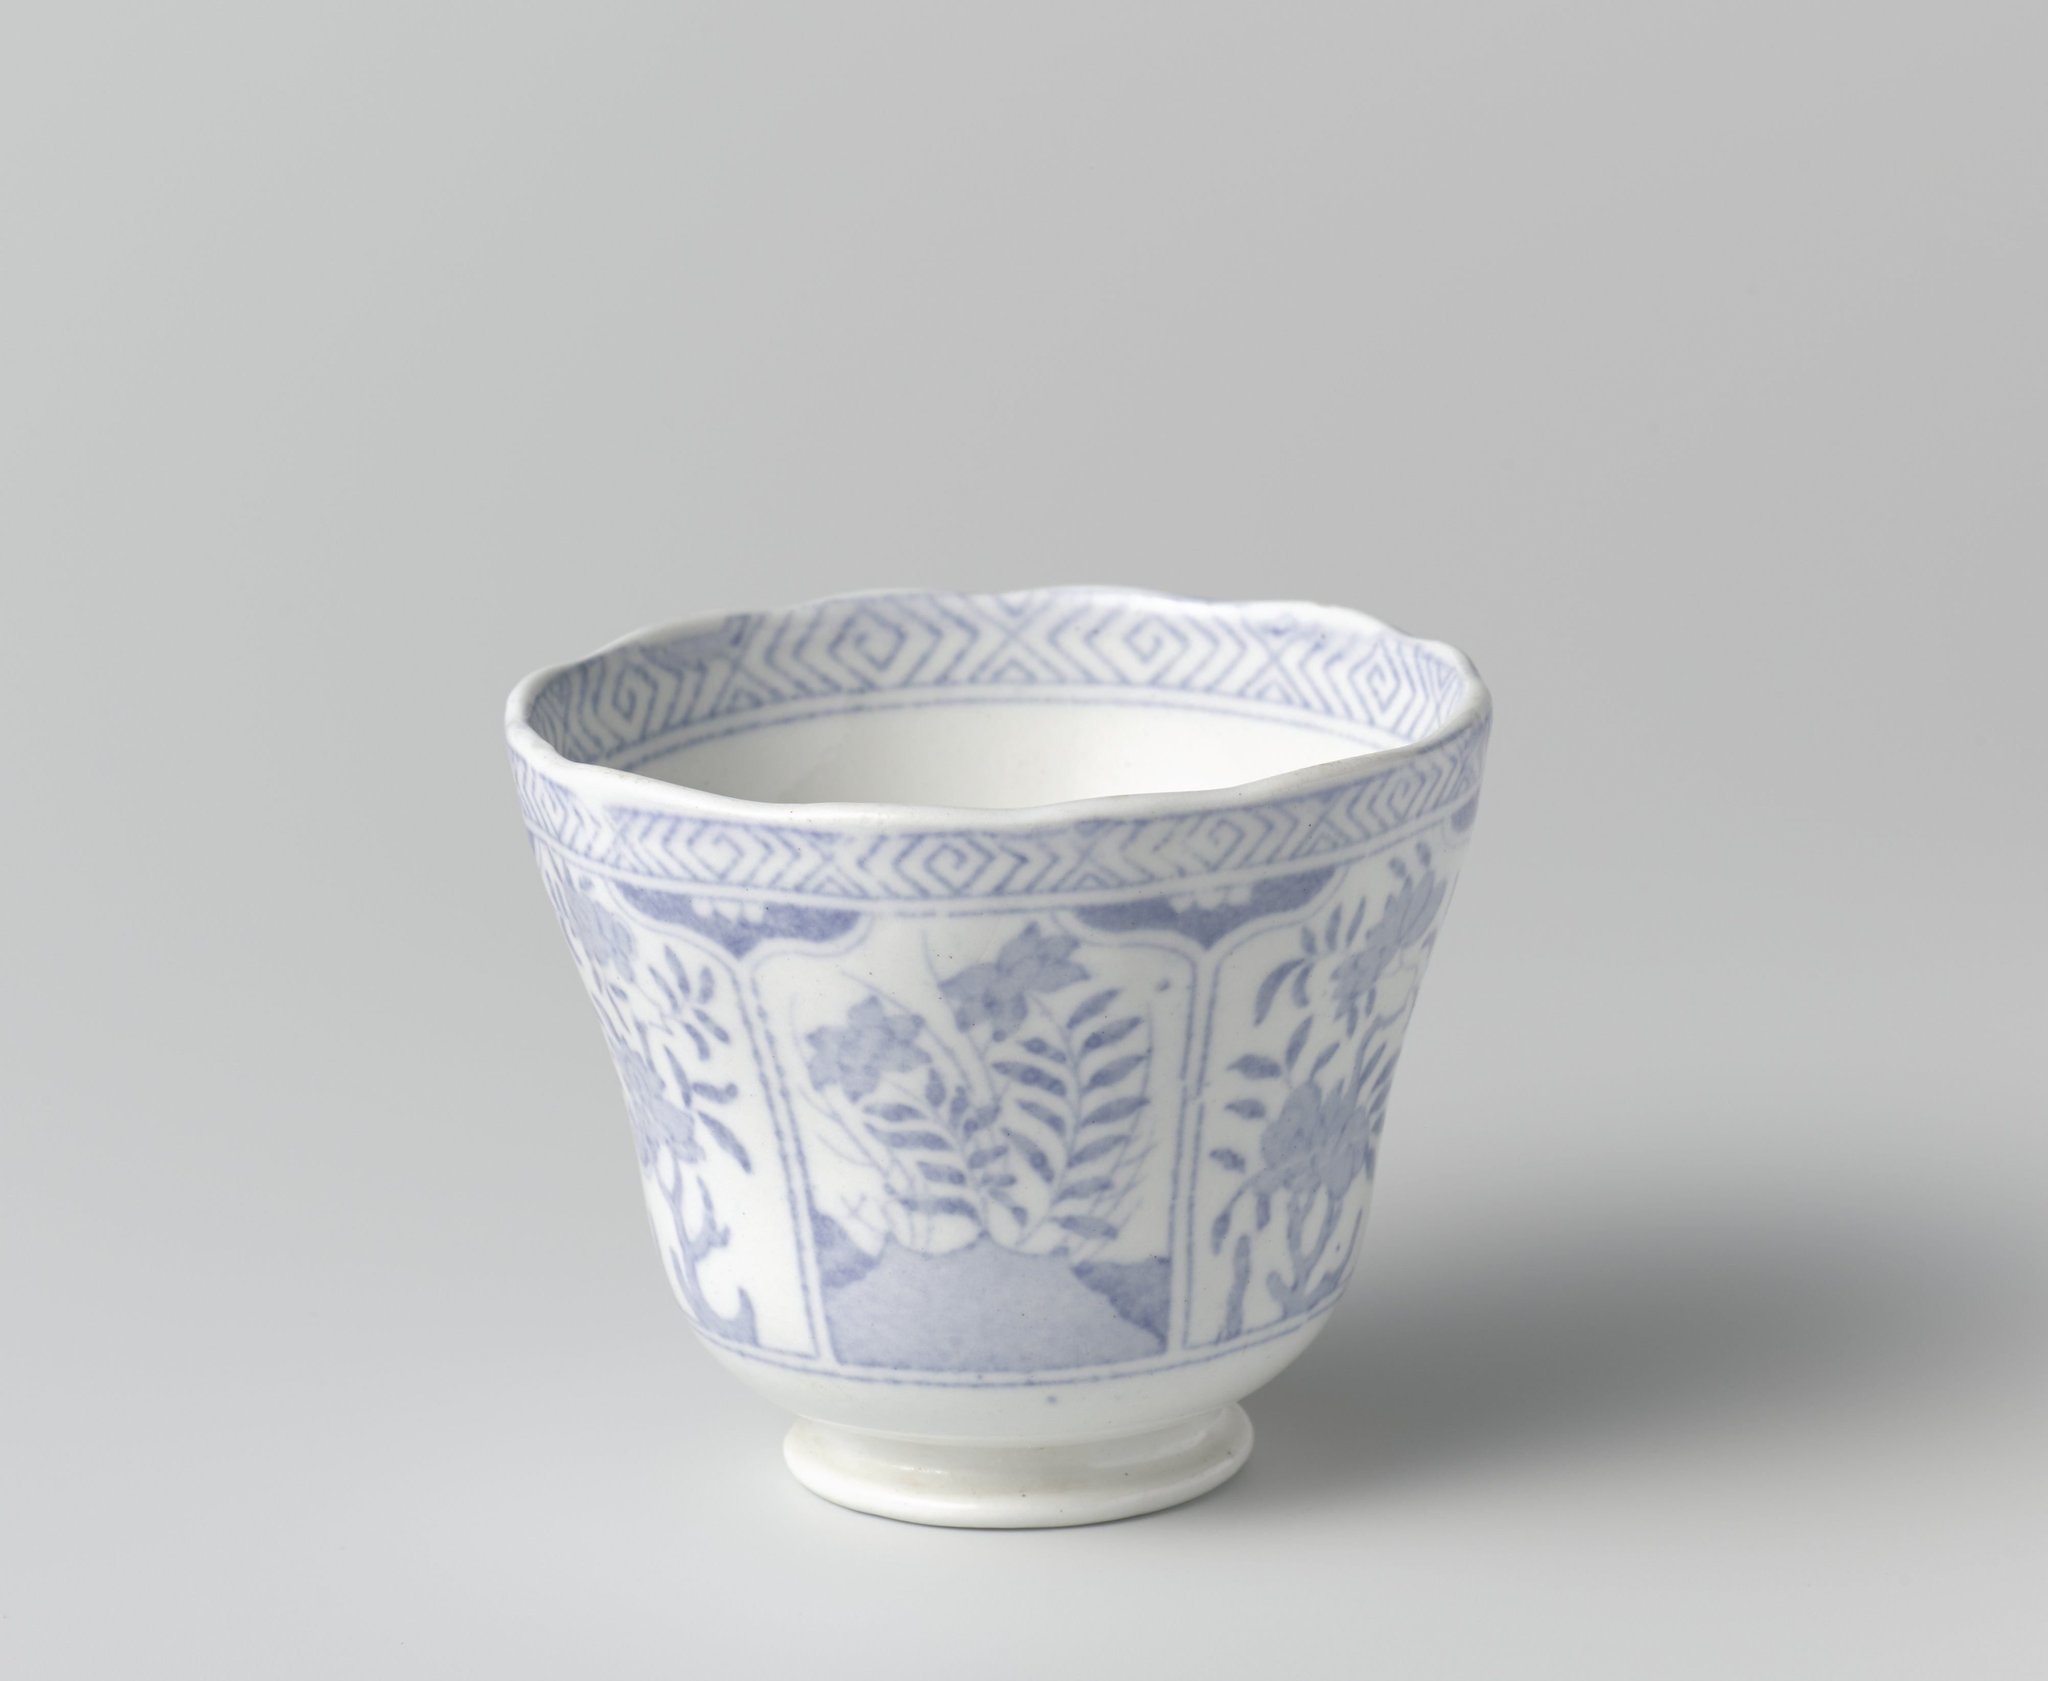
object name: cup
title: Kop zonder oor, met geschulpte mondrand en vakken met bloemen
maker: petrus regout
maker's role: plateelbakker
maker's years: 1801-1879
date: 1801-1879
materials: earthenware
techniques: transfer decoration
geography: maastricht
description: Kop zonder oor van aardewerk met vloeiblauw transferdecor. De wand van de kop met vakken met bloemen. De geschulpte mondrand is aan binnen en buitenzijde afgezet met een lijnenpatroon.